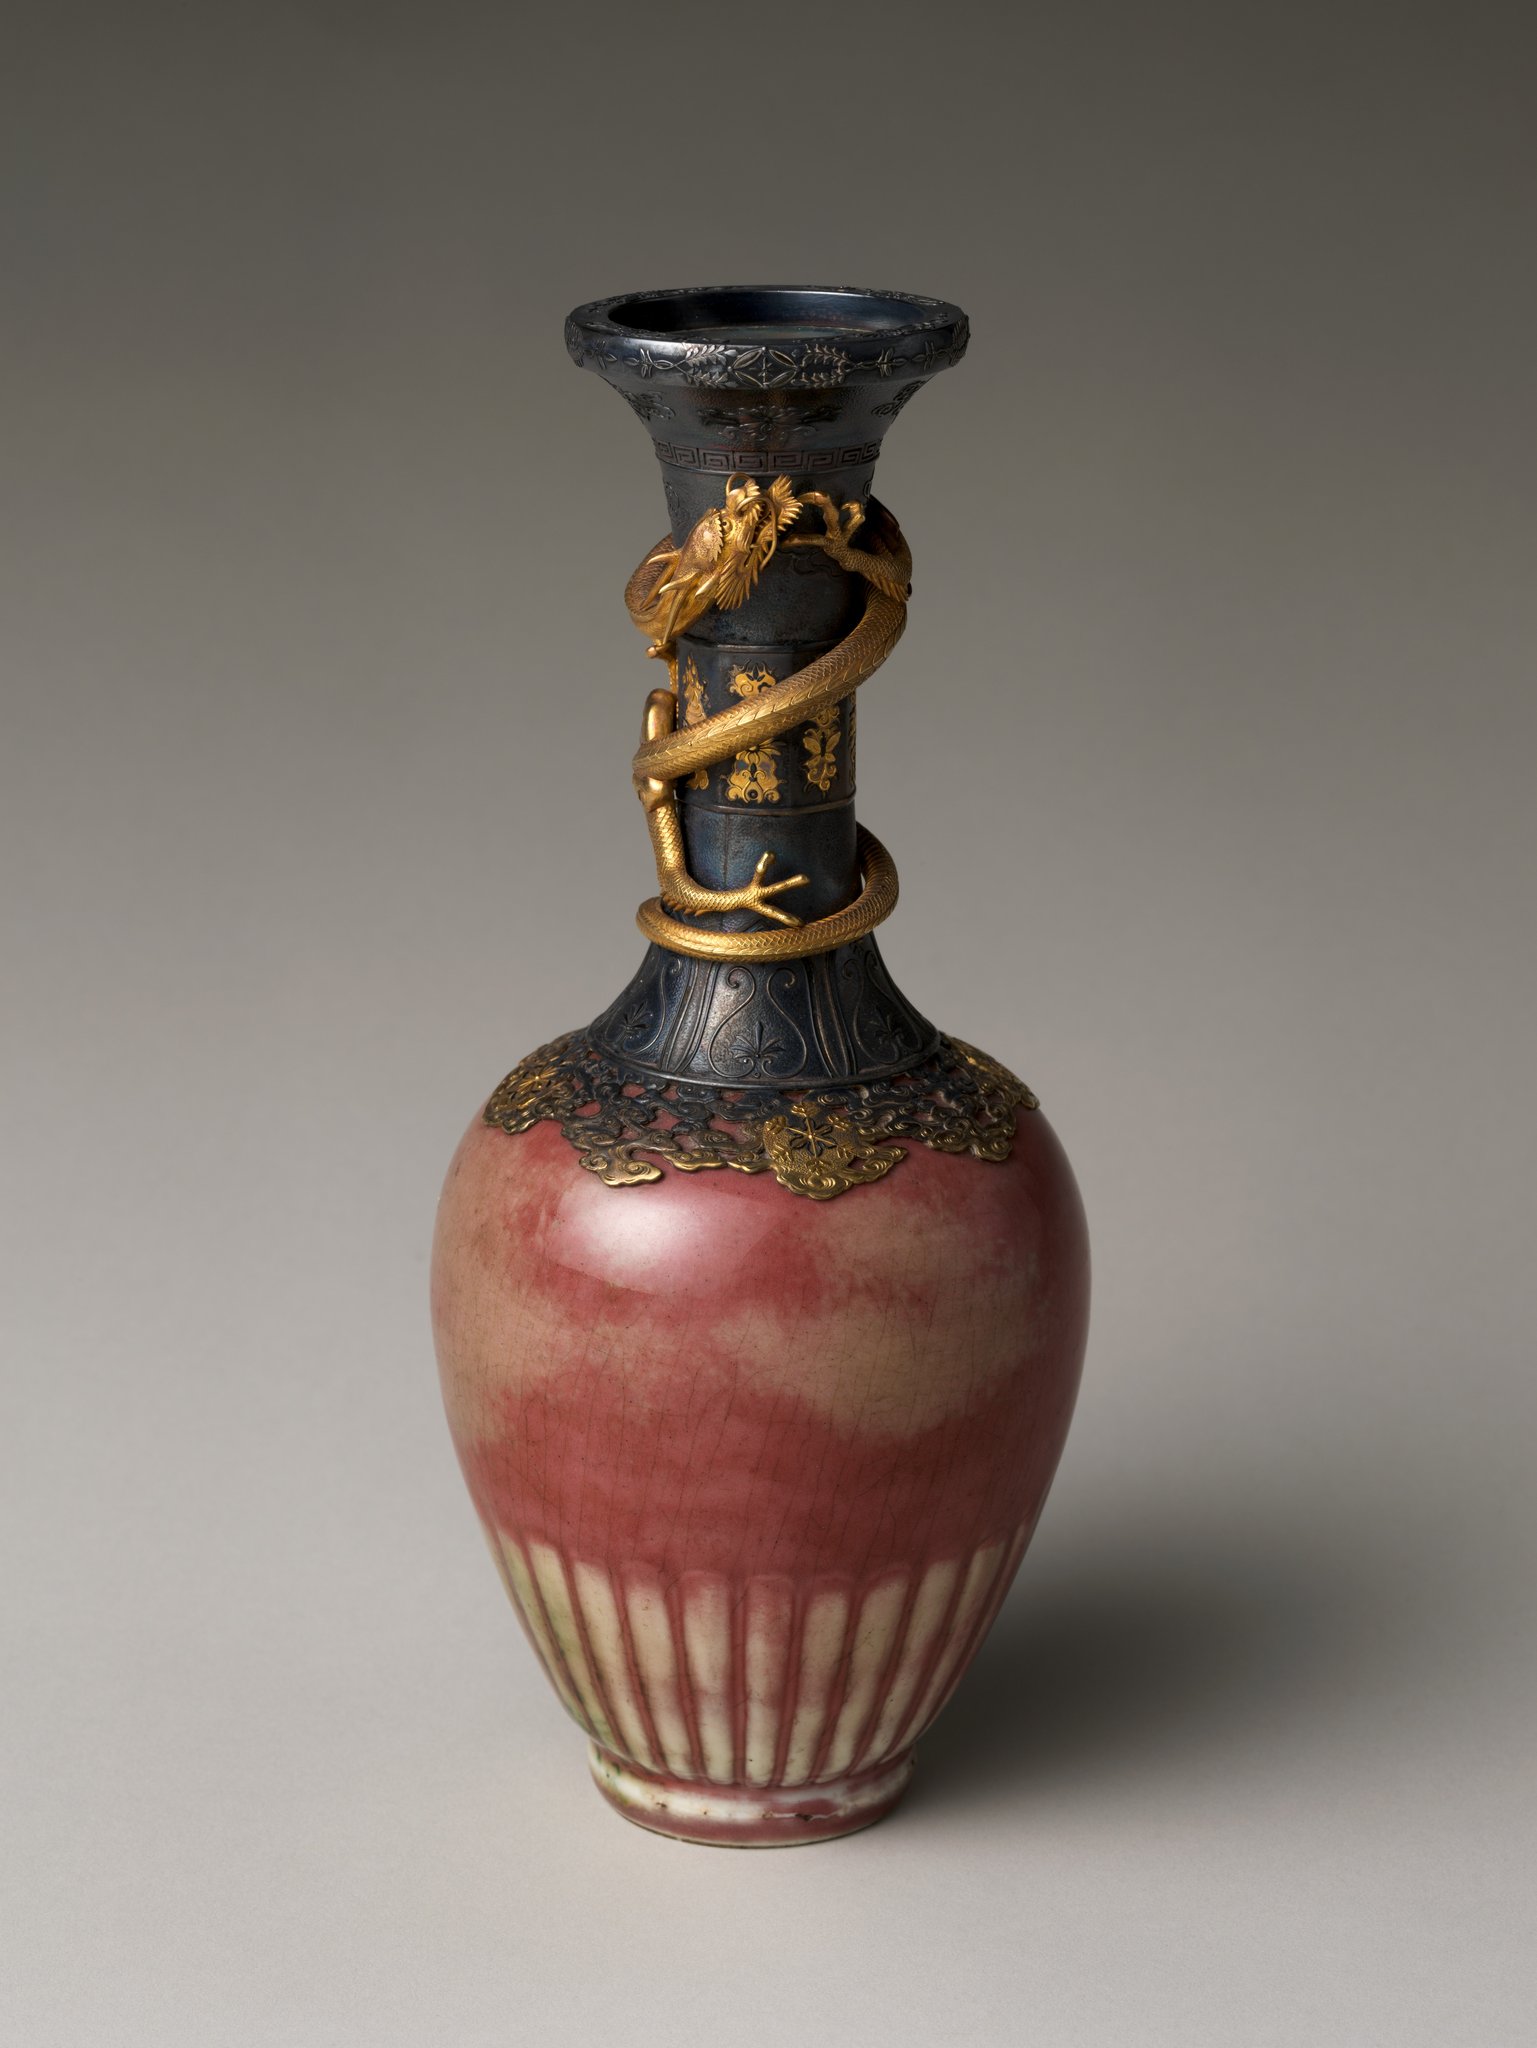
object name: vase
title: Vase with Coiling Dragon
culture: chinese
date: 1678-1688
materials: glaze, porcelain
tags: dragons